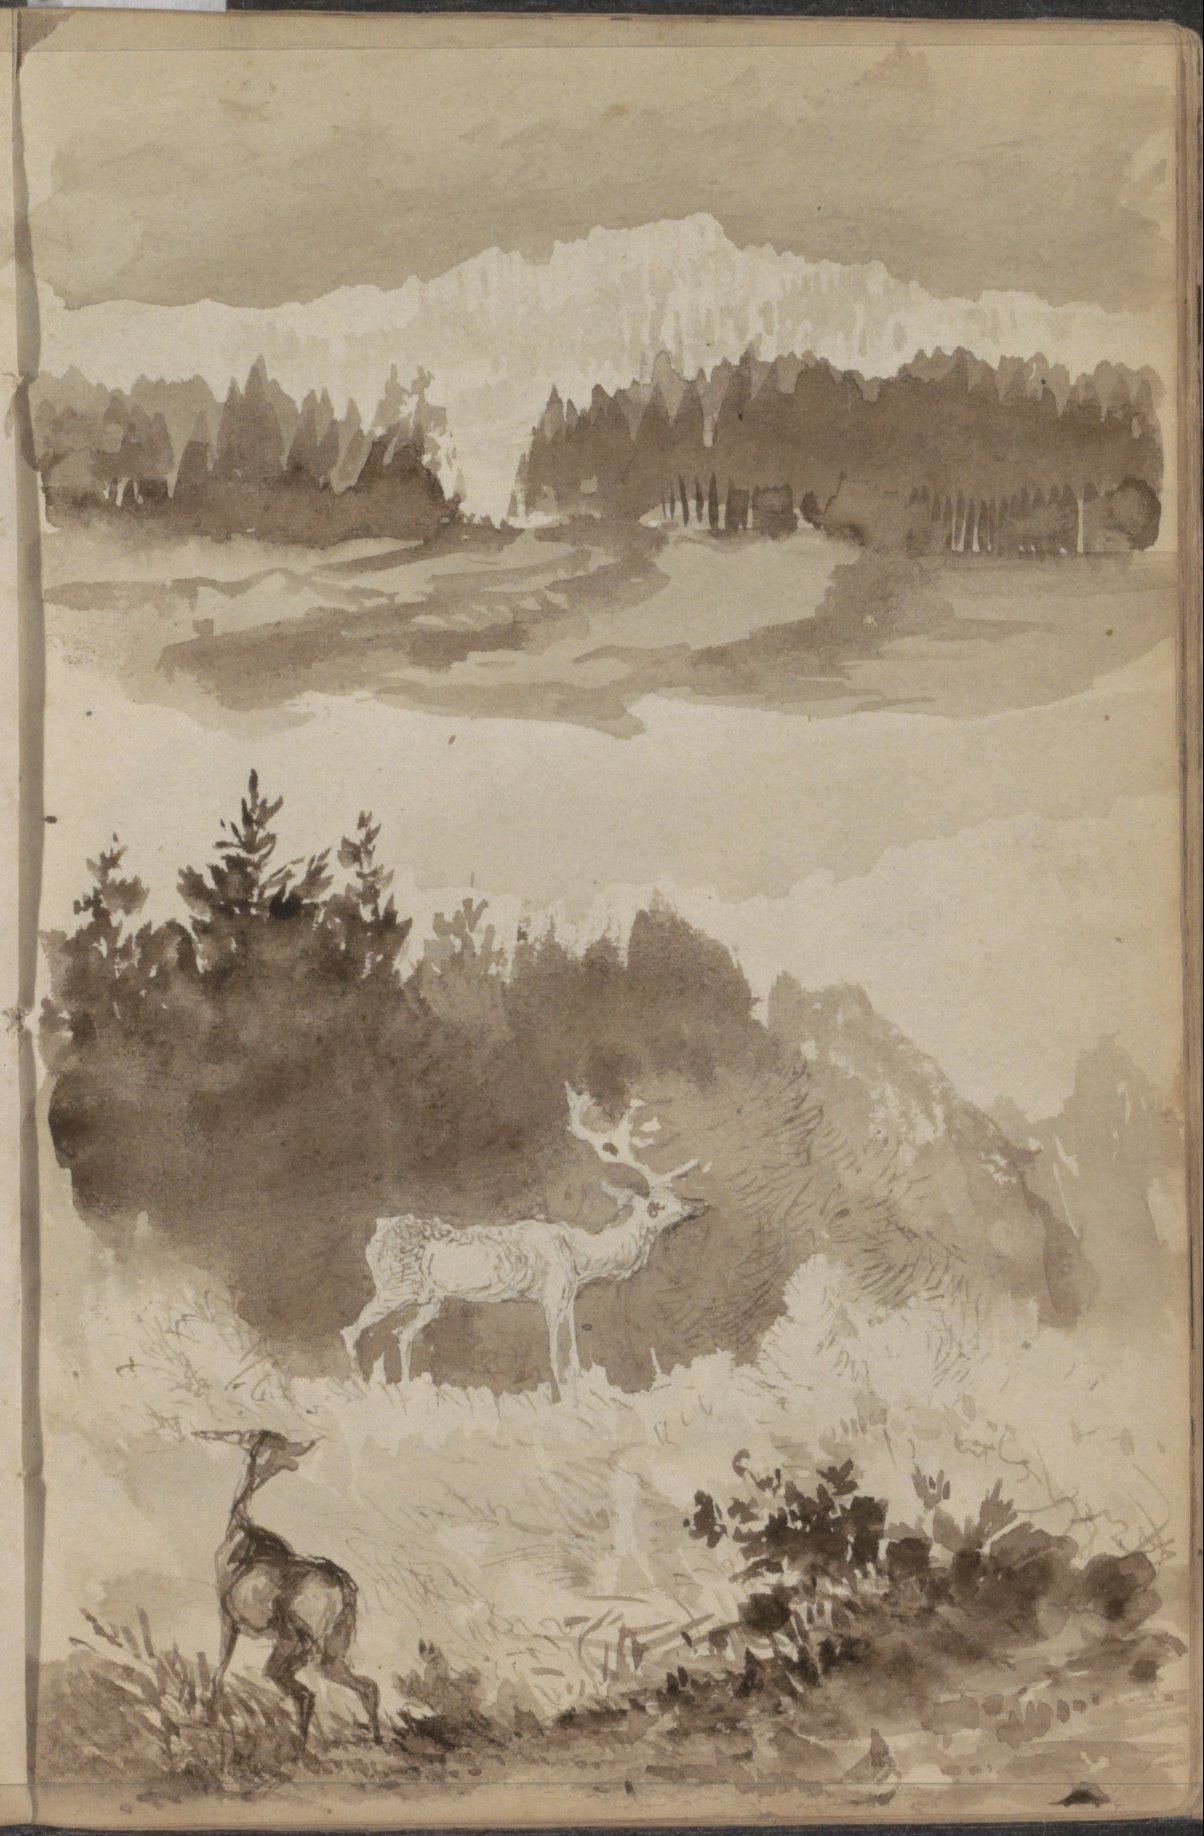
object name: sketchbook leaf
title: Berglandschap en twee herten bij bomen en struiken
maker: johannes tavenraat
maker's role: draughtsman, painter, print maker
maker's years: 1809-1881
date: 1858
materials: ink, paper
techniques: brush, pen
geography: bohemia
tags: trees, hoofed animals: deer, shrubs, mountains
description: Blad 25 recto uit een schetsboek met 44 bladen.